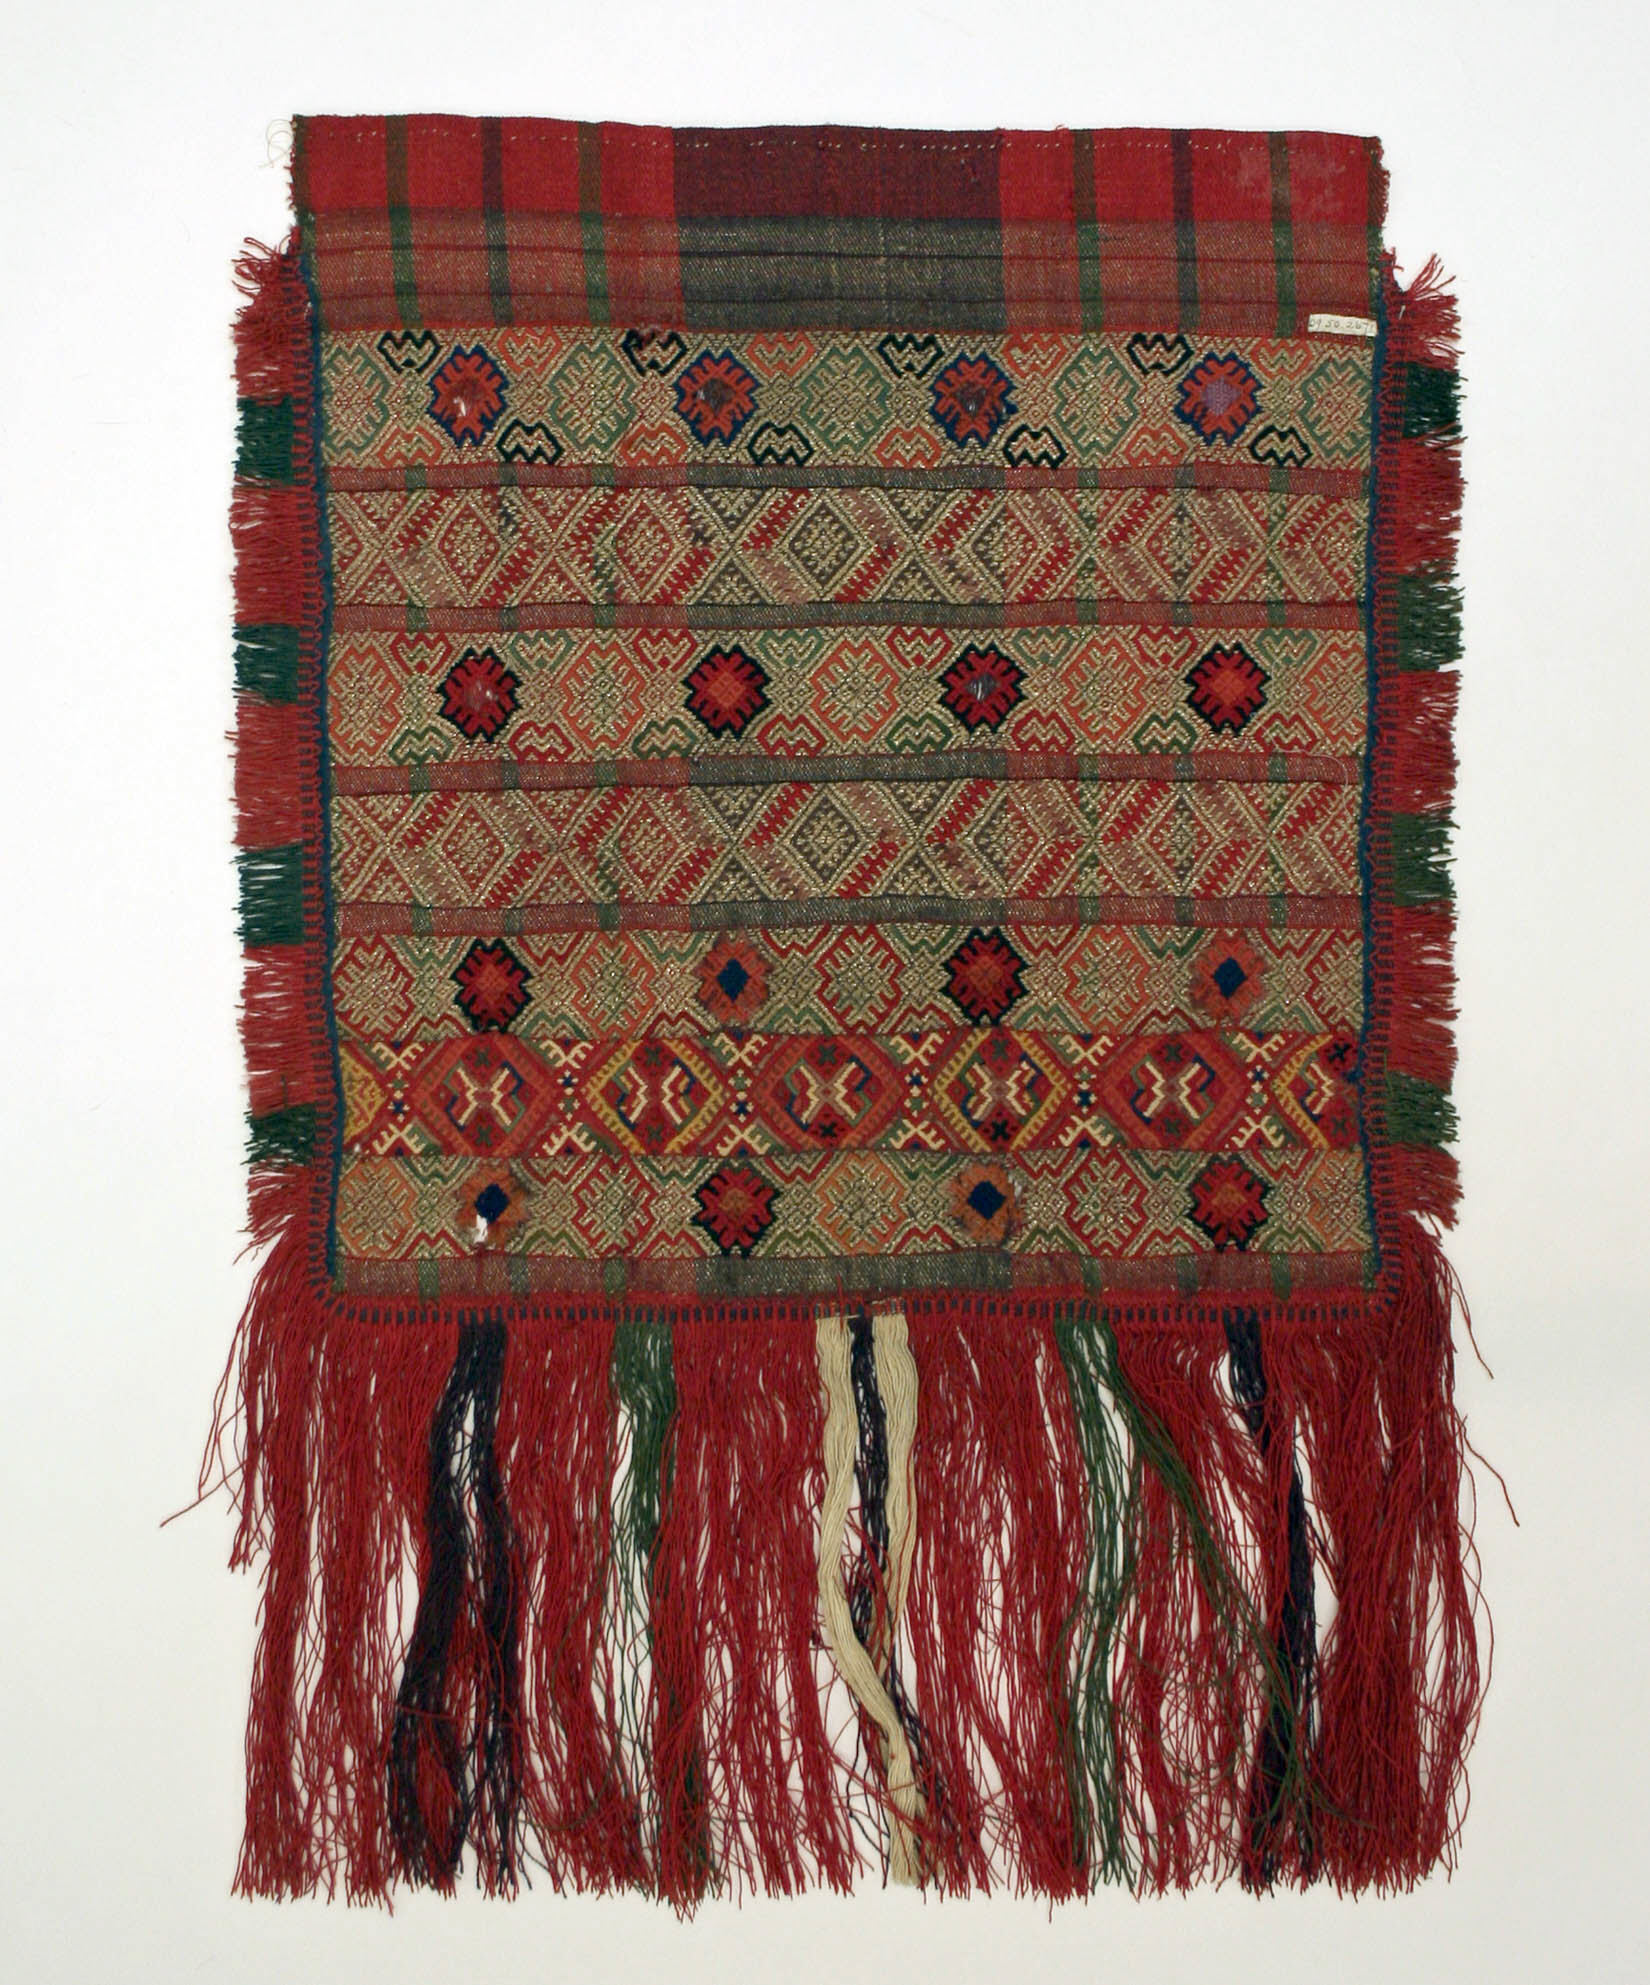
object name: apron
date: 1801-1900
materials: wool